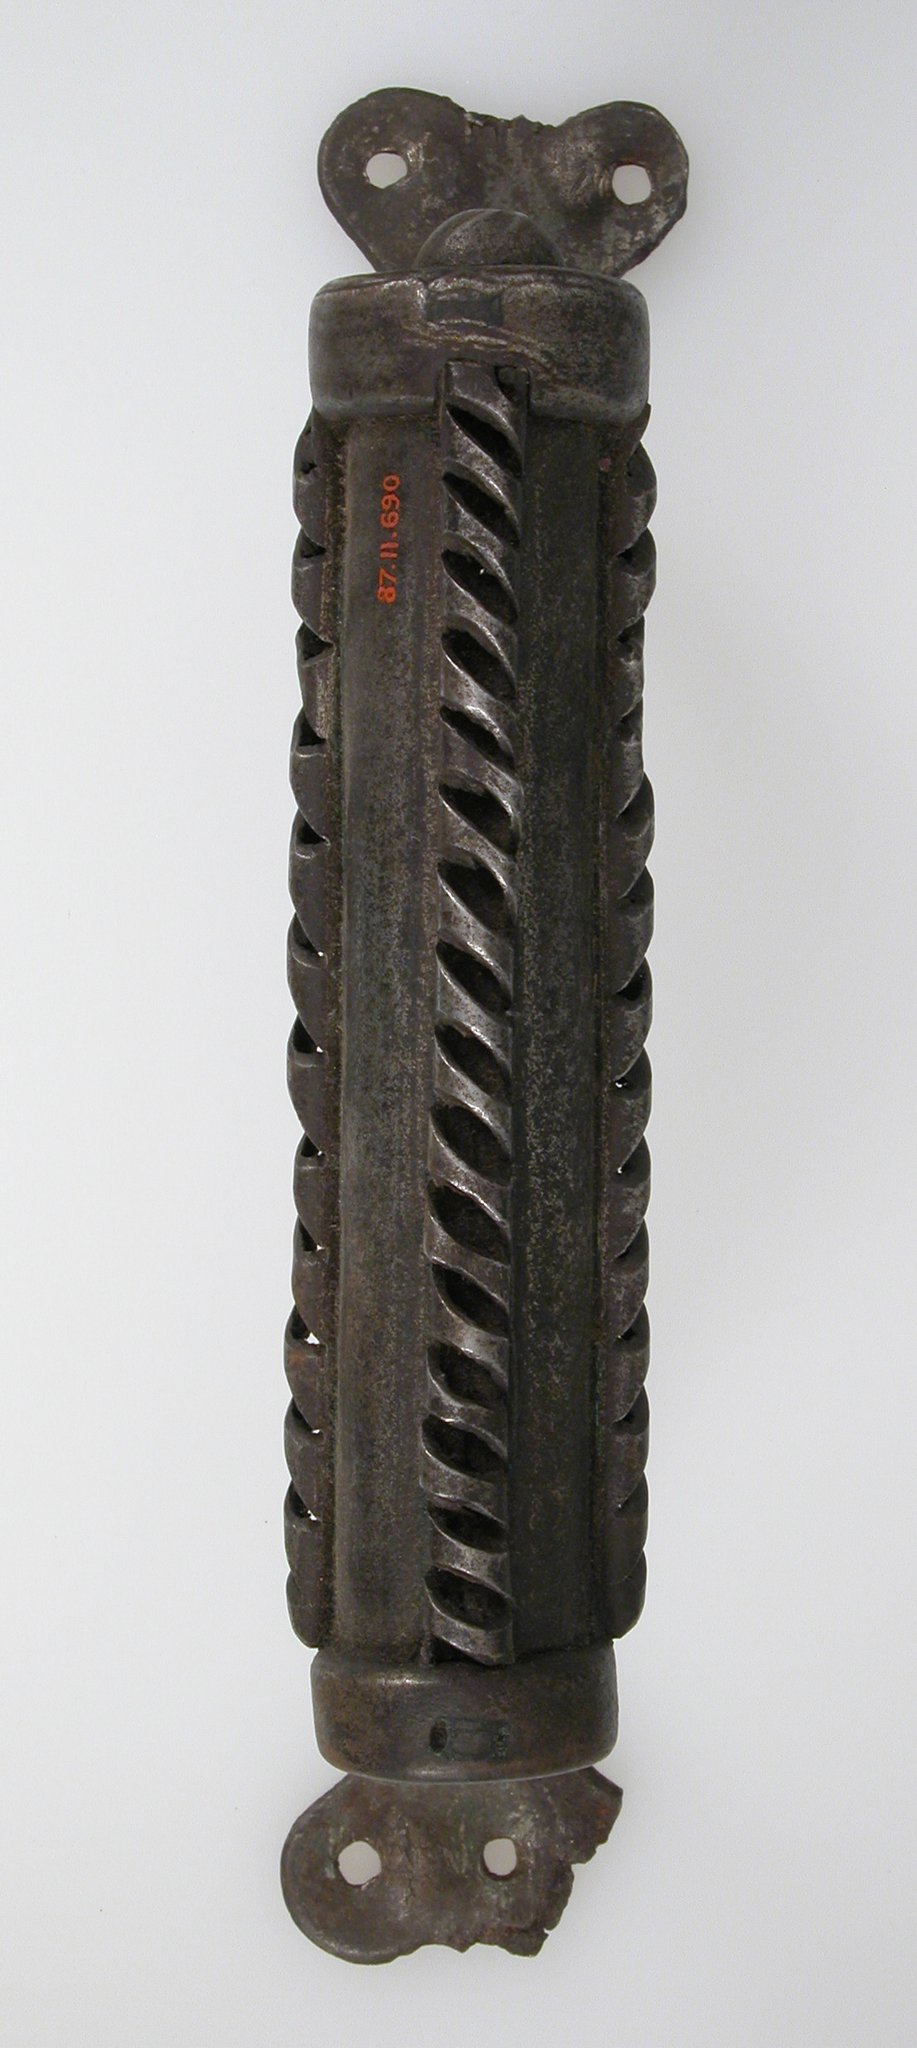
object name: door handle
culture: german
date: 1401-1500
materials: iron